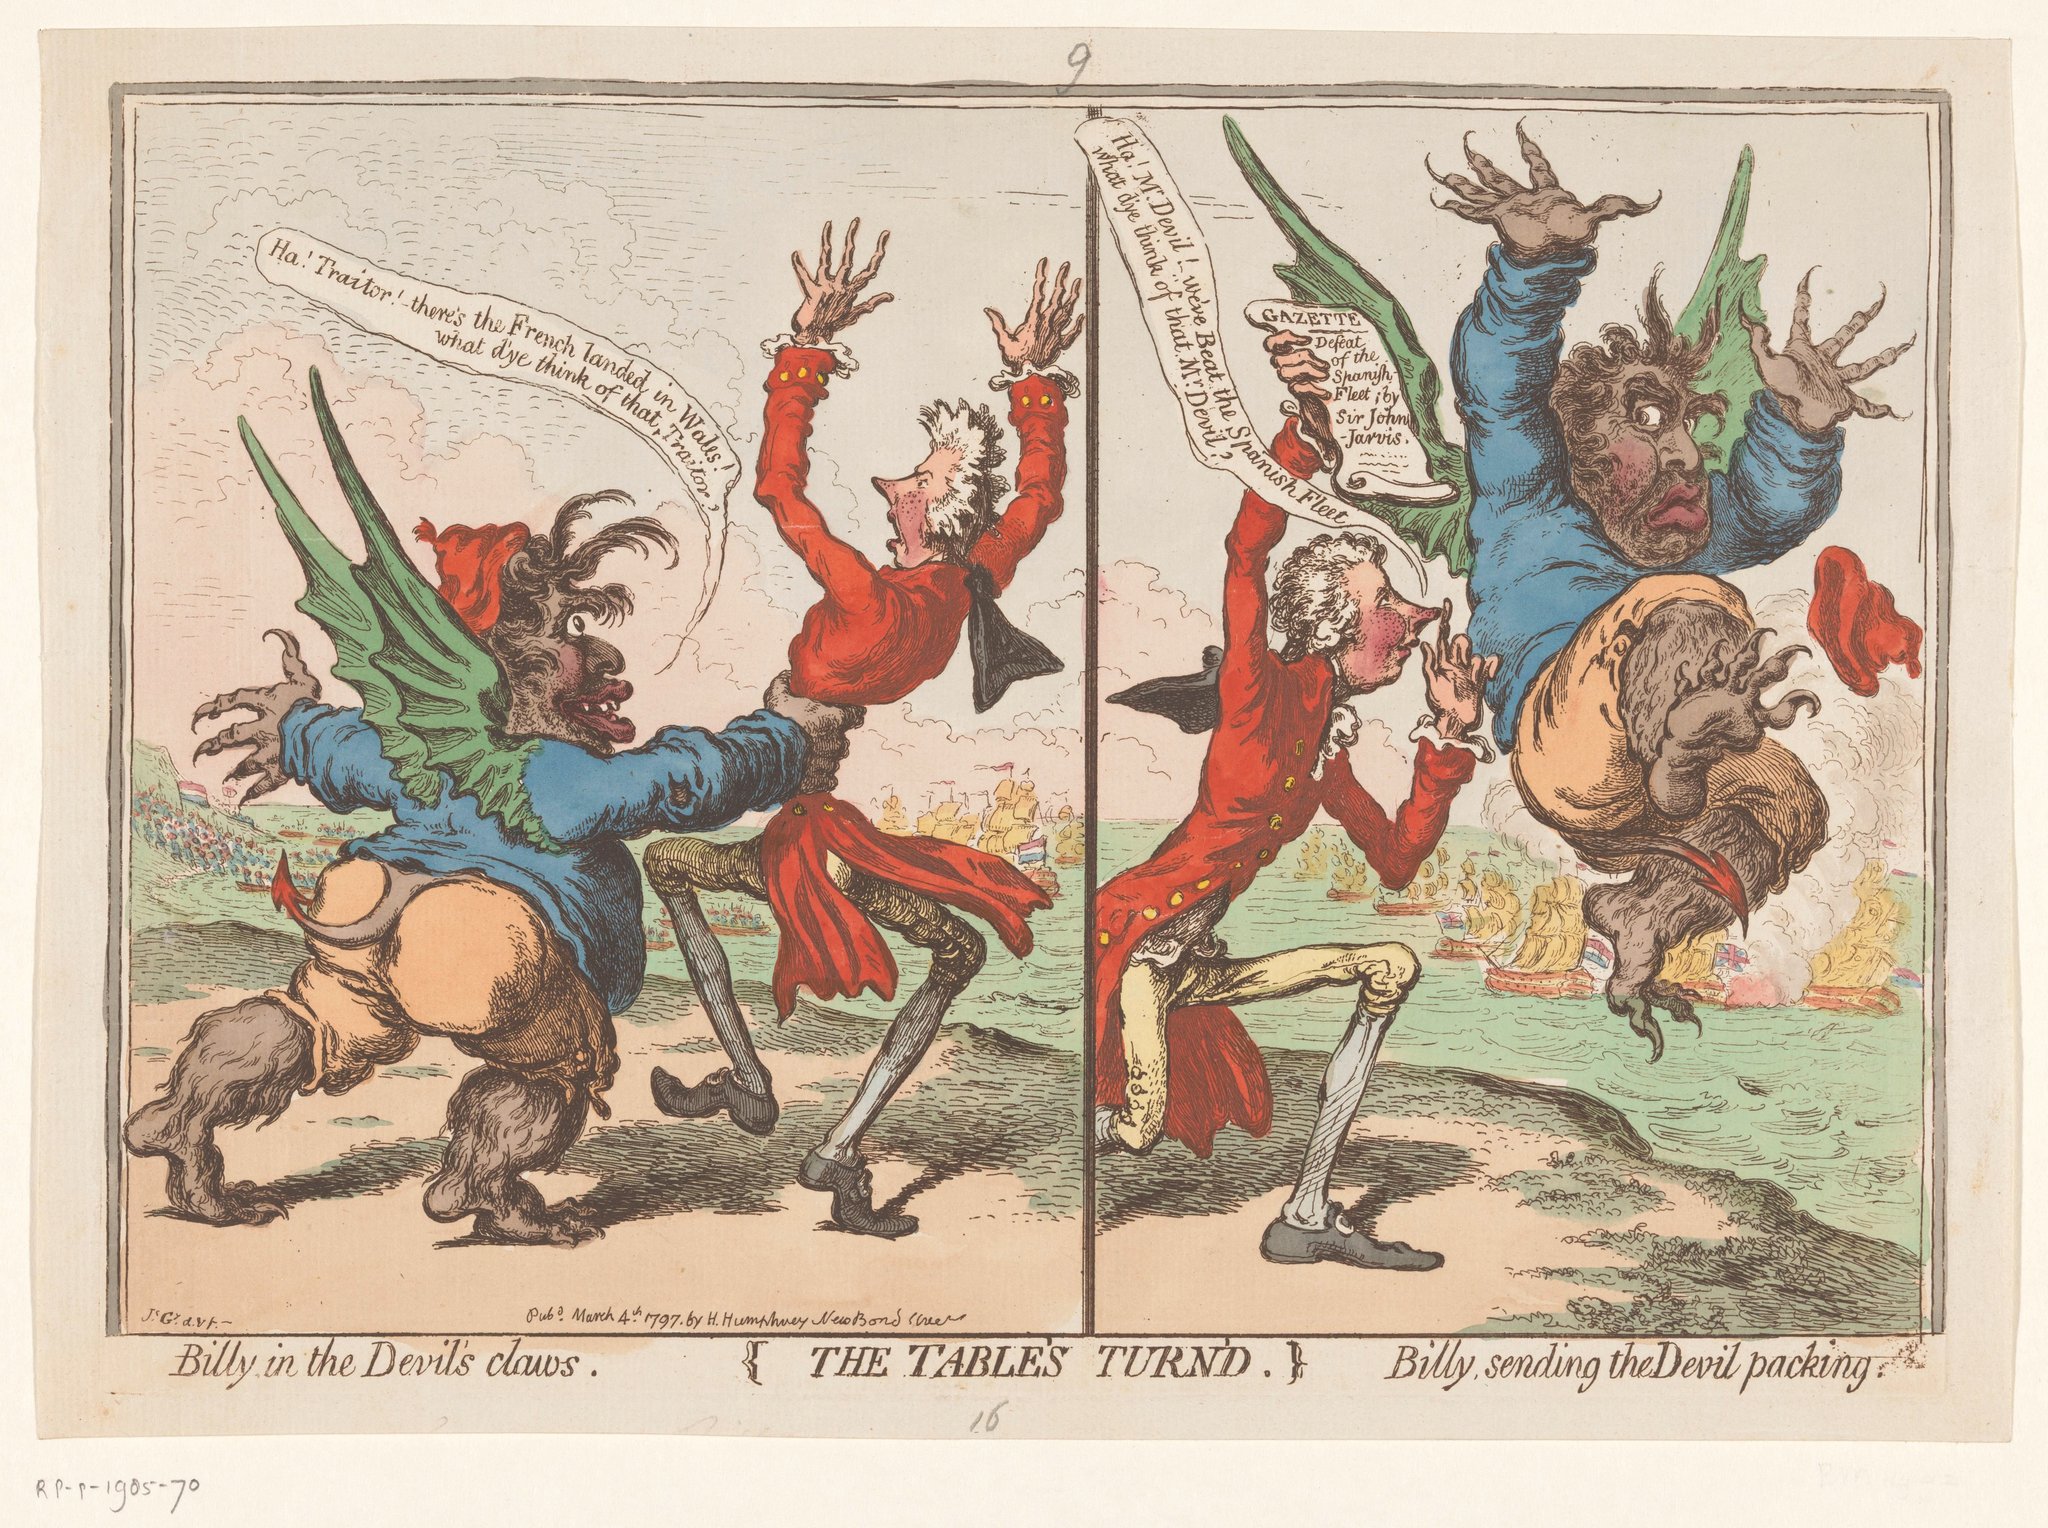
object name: print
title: Spotprent op William Pitt en Charles Fox, 1797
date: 1797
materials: paper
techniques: etching, hand coloring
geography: england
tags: london, (military) attack, putting the enemy to flight, political caricatures and satires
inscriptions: collector's mark: Lugt 2760, collector's mark: Lugt 2228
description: Spotprent met twee voorstellingen van het wisselende fortuin van William Pitt de Jonge en Charles James Fox, 1797. Links grijpt Fox (voorgesteld als een Franse duivel), Pitt bij de middel, op de achtergrond de landing van een legertje Fransen (La Légion noire) in Wales onder aanvoering van Colonel William Tate op 22 februari. Rechts verjaagt Pitt Fox, op de achtergrond worden de schepen van Tate op 25 februari verslagen en verjaagd.